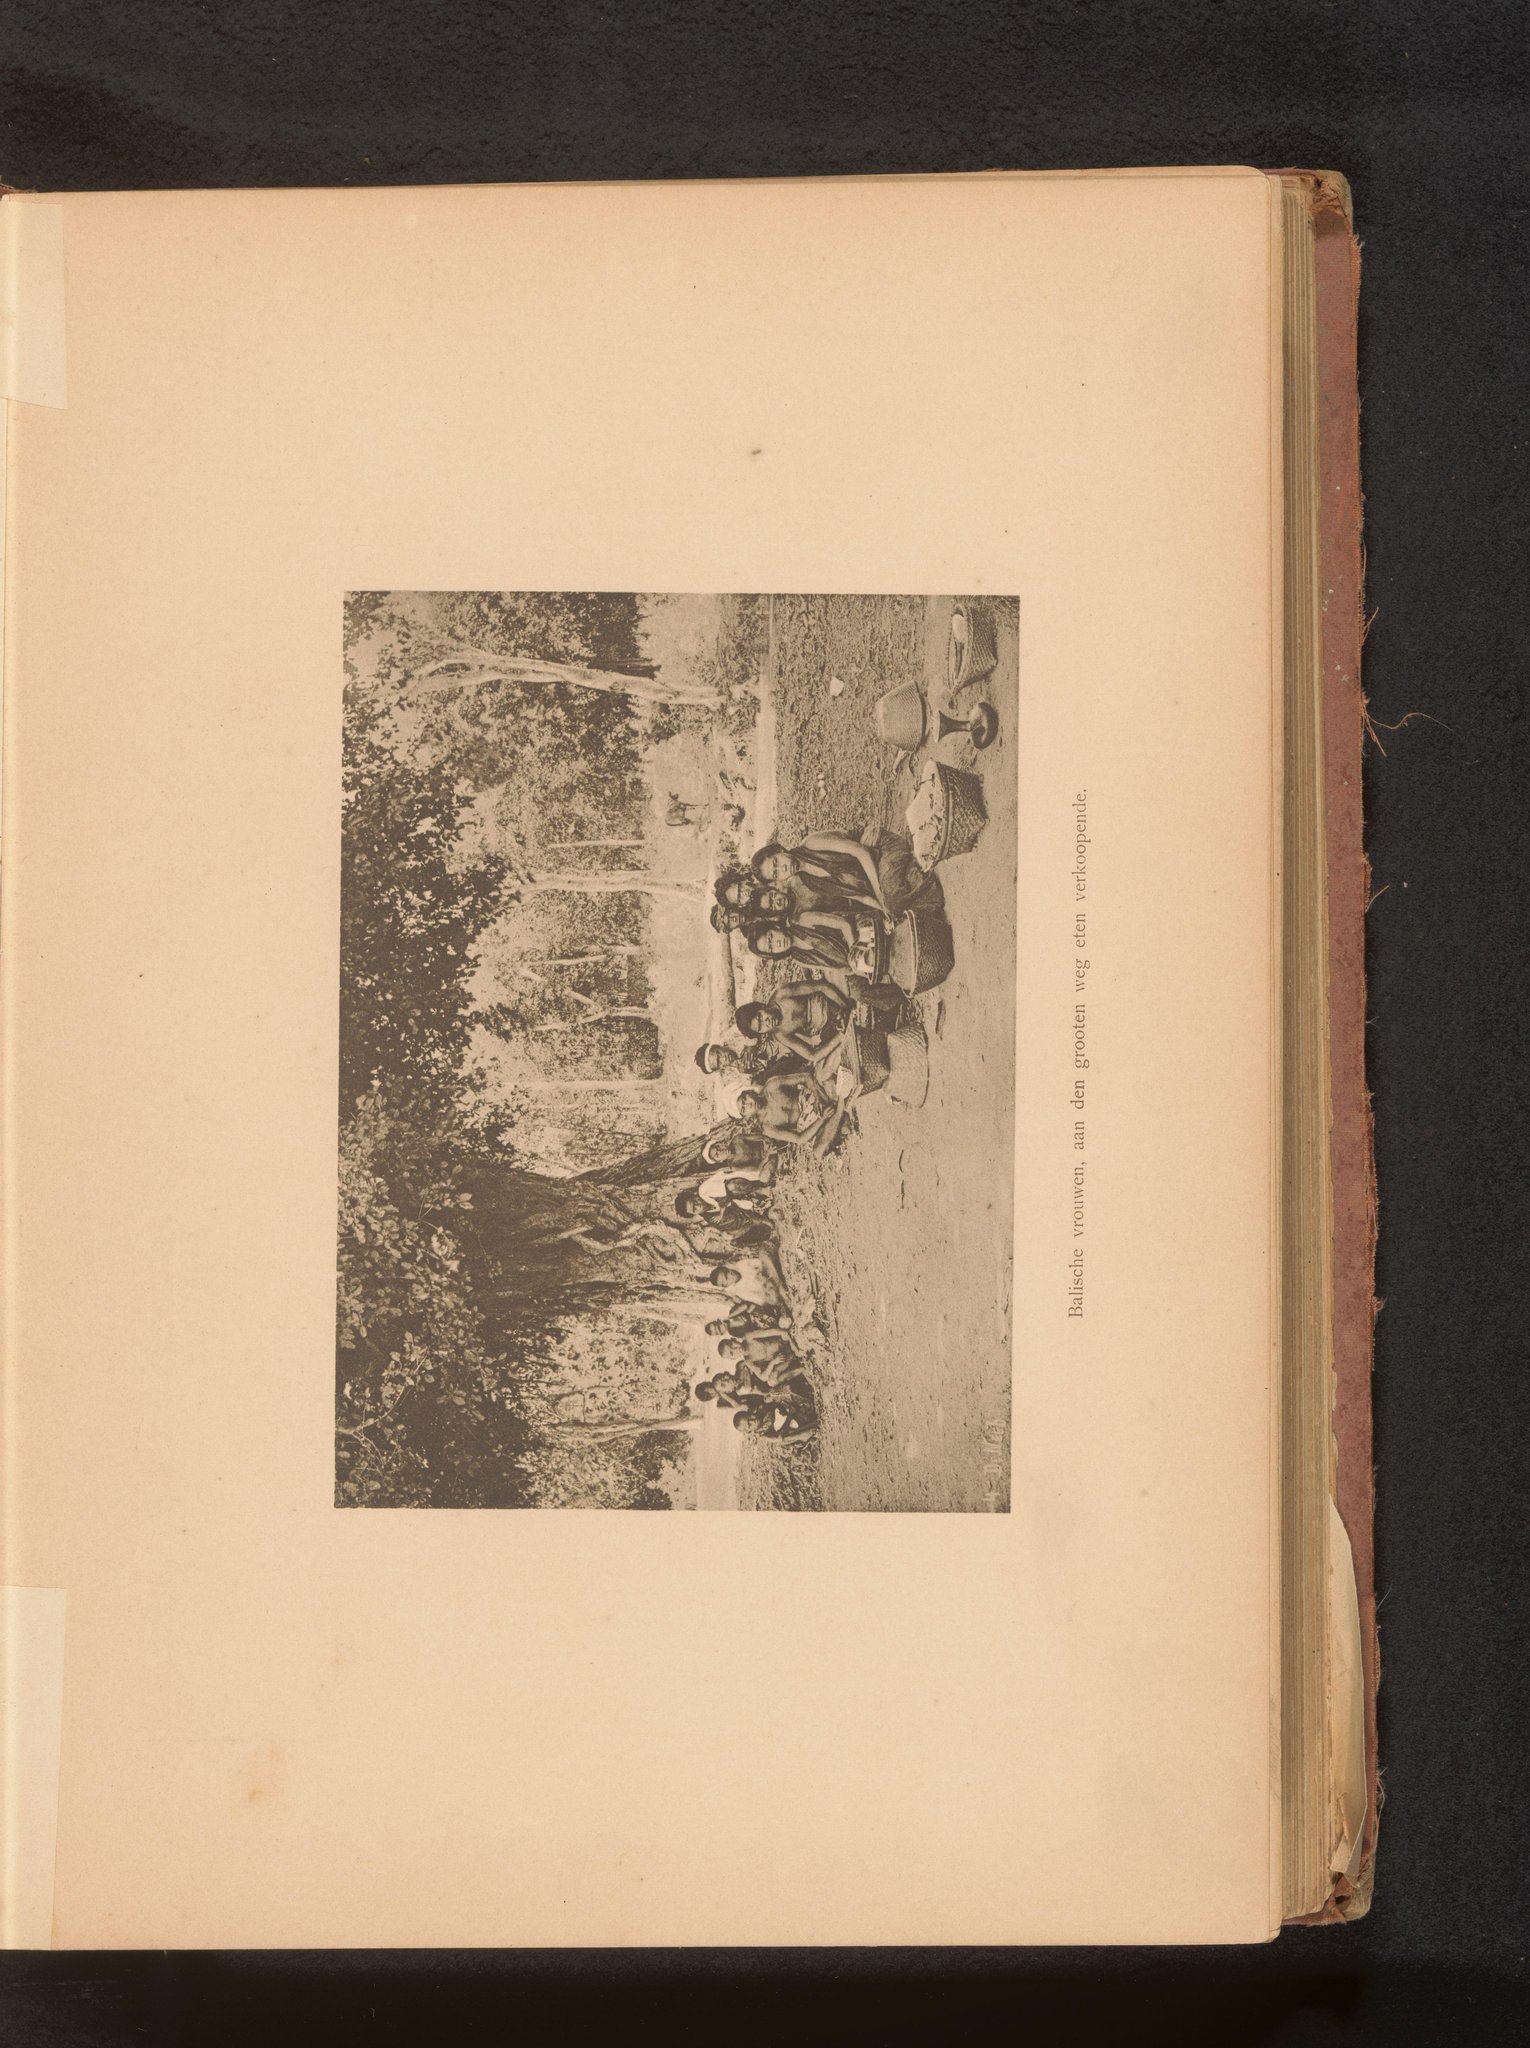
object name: page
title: Groep onbekende personen die langs de weg eten verkopen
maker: christiaan johan neeb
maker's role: arts, fotograaf, officier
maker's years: 1860-1925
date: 1892-1897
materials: paper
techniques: photograph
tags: anonymous historical persons portrayed in a group, in a group-portrait